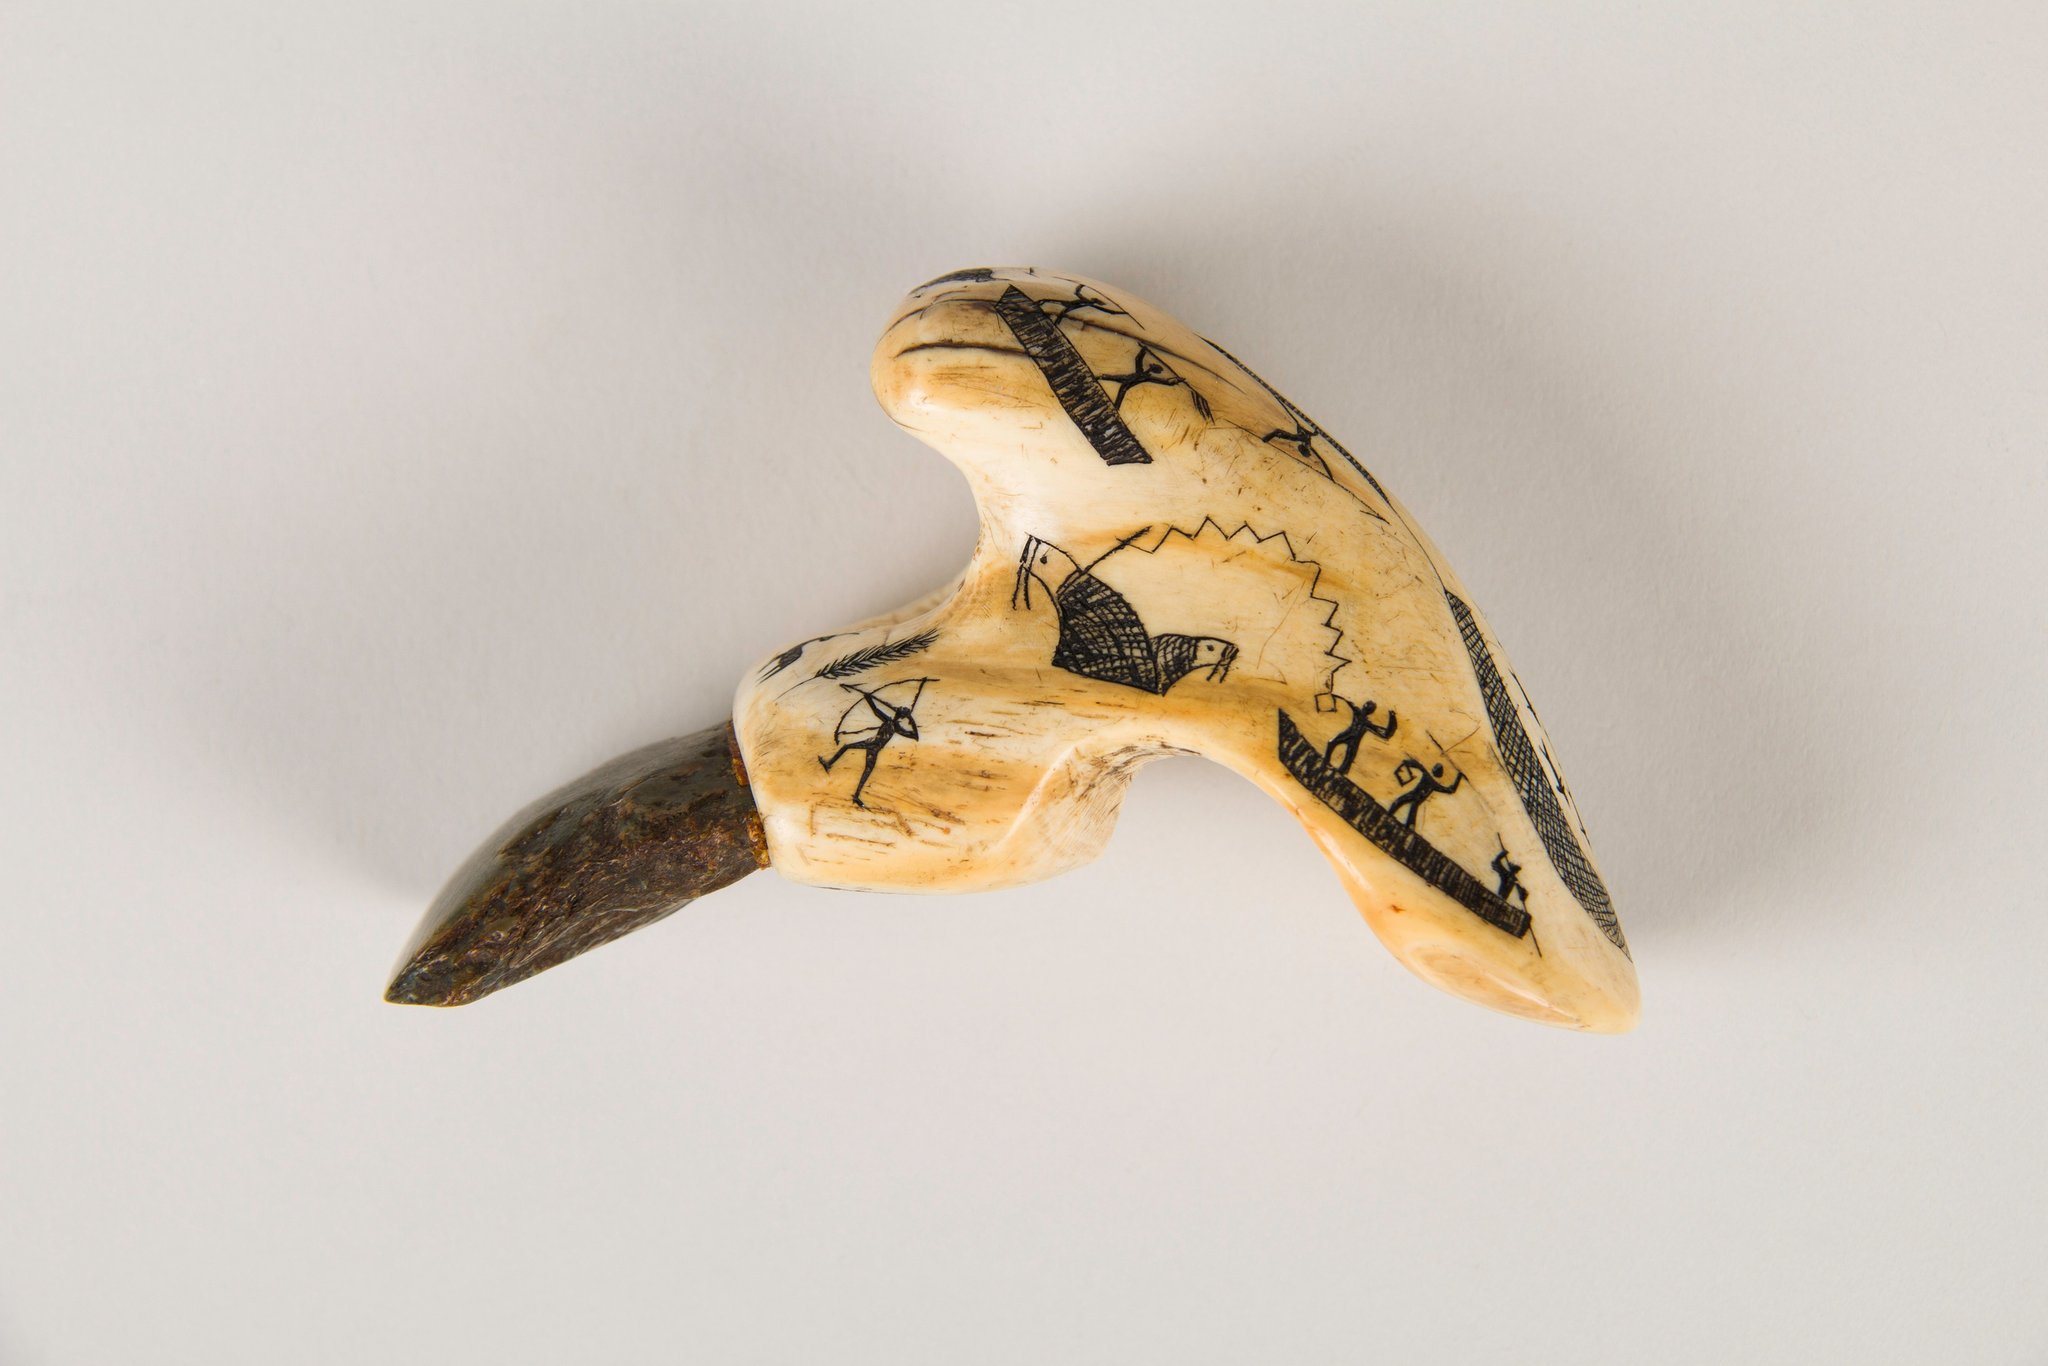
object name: scraper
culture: north american, alaskan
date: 1902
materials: jade